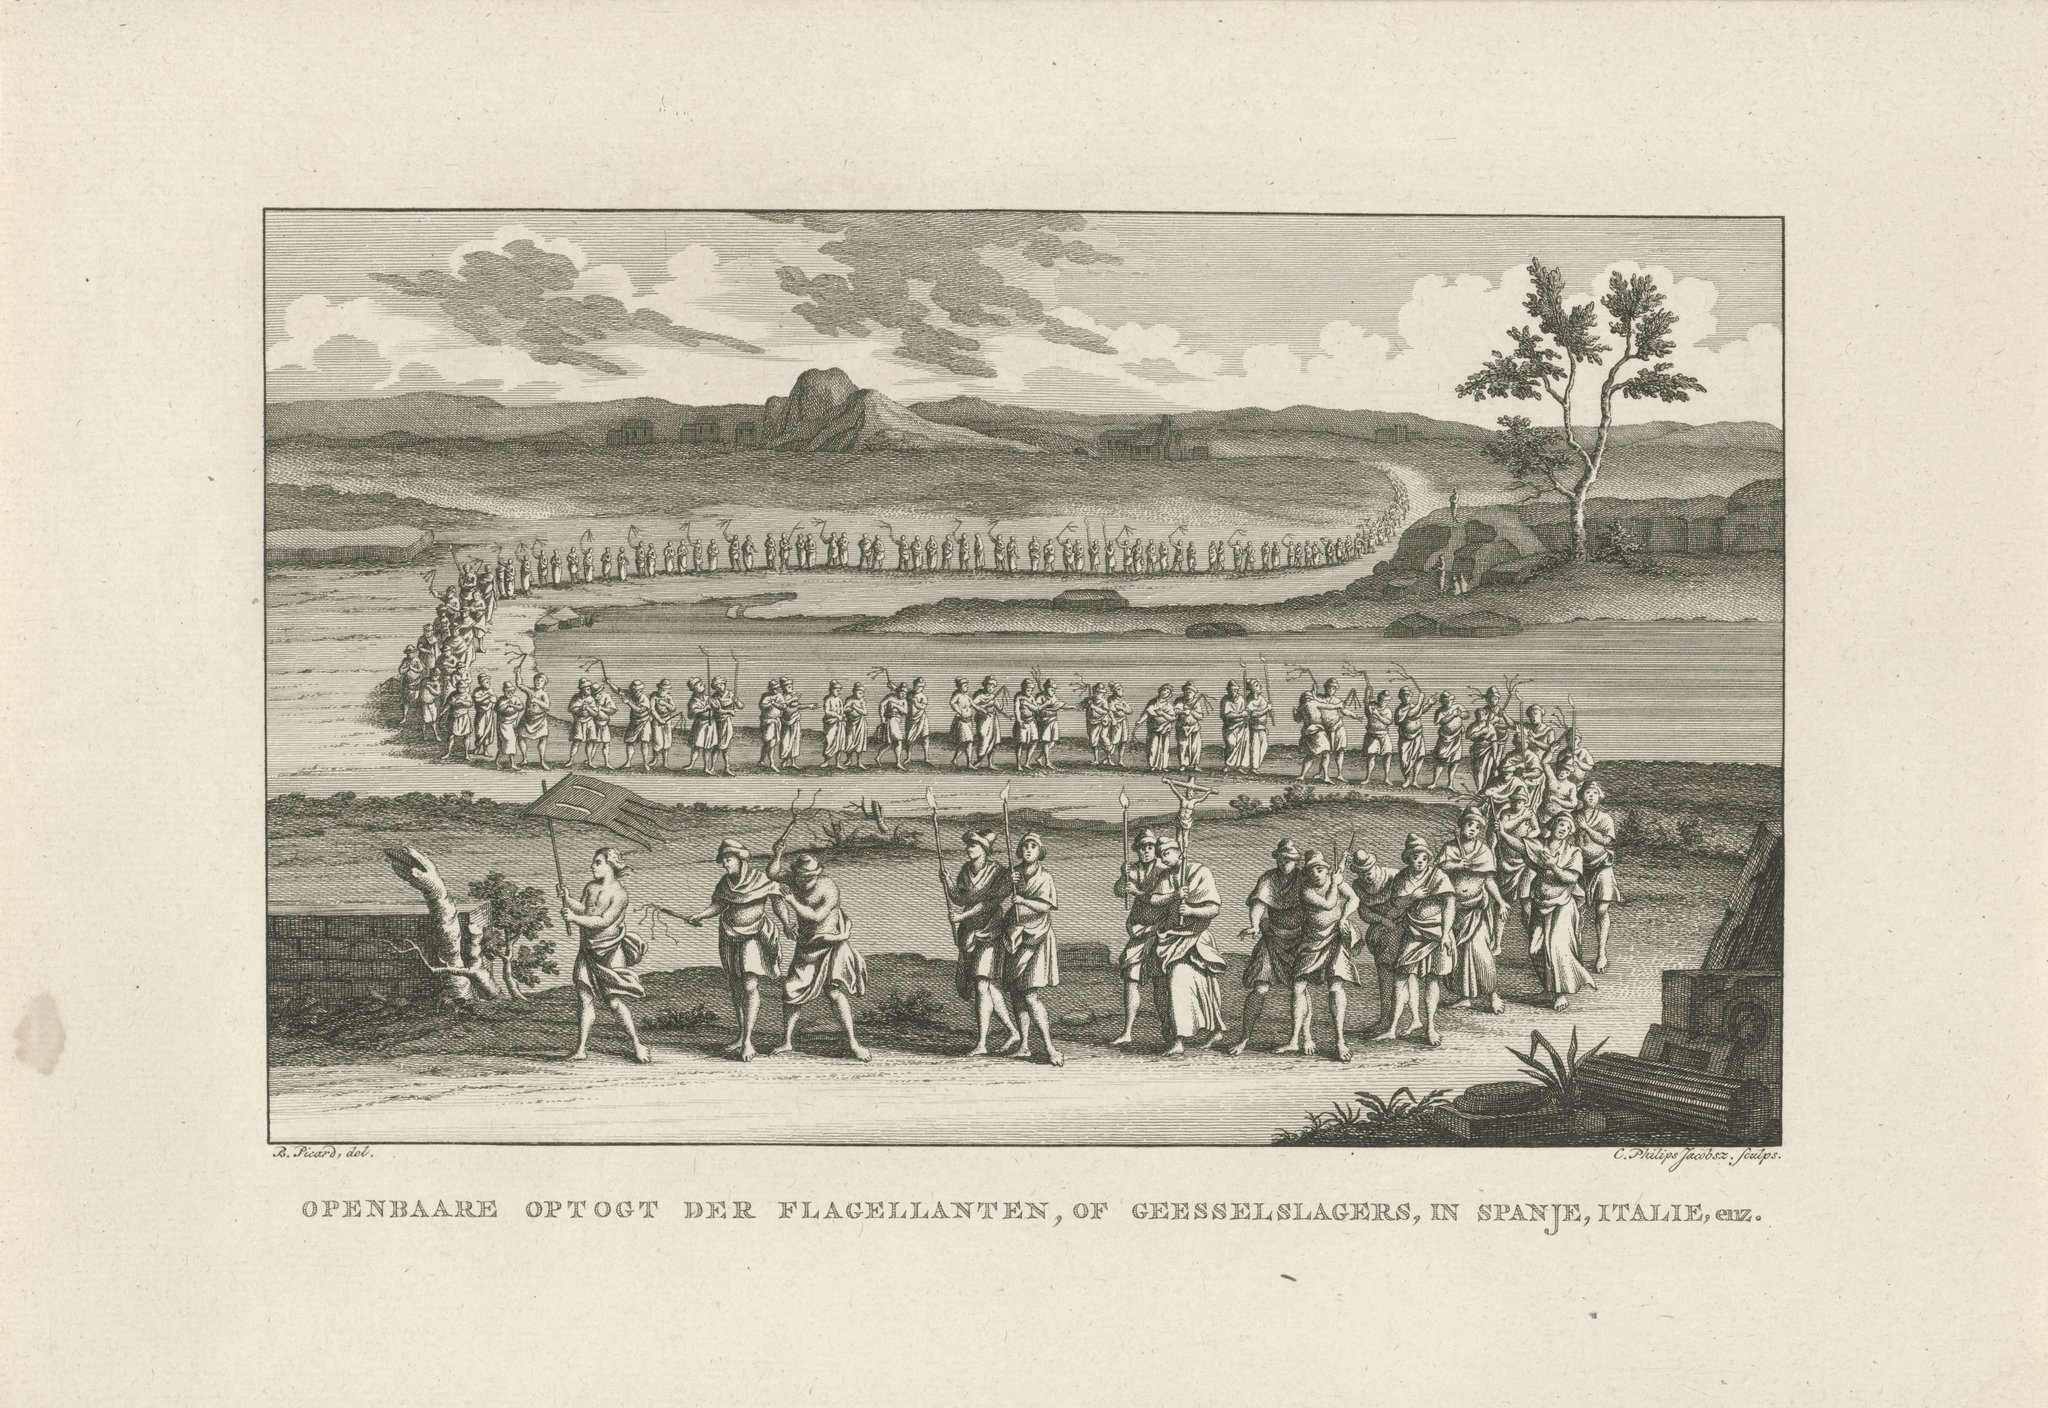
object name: print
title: Processie van flagellanten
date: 1752-1789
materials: paper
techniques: etching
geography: amsterdam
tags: flagellants ~ ascetic life, self-castigation ~ ascetic life, procession ~ christian religion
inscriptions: collector's mark: Lugt 2228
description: Landschap met processie van flagellanten. Dit waren gelovigen die zichzelf ritueel geselden.